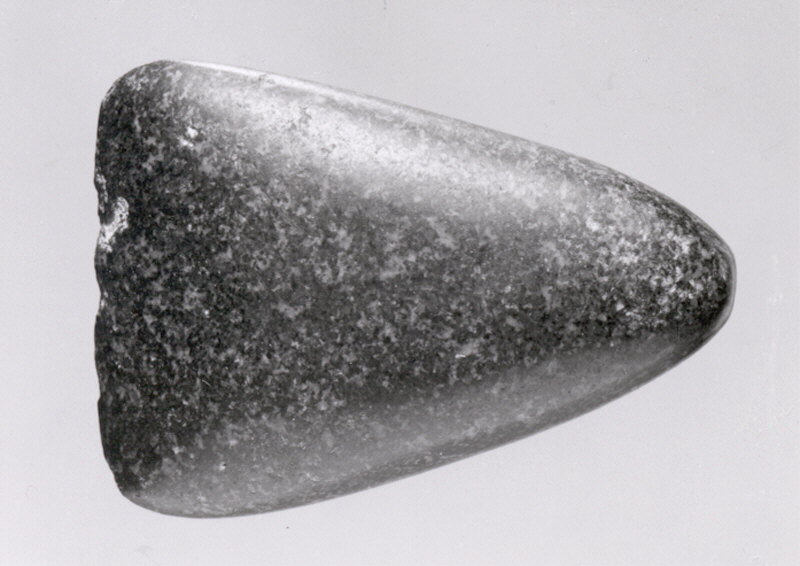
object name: axe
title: Axe head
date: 3000-2001 BCE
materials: stone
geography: anatolia